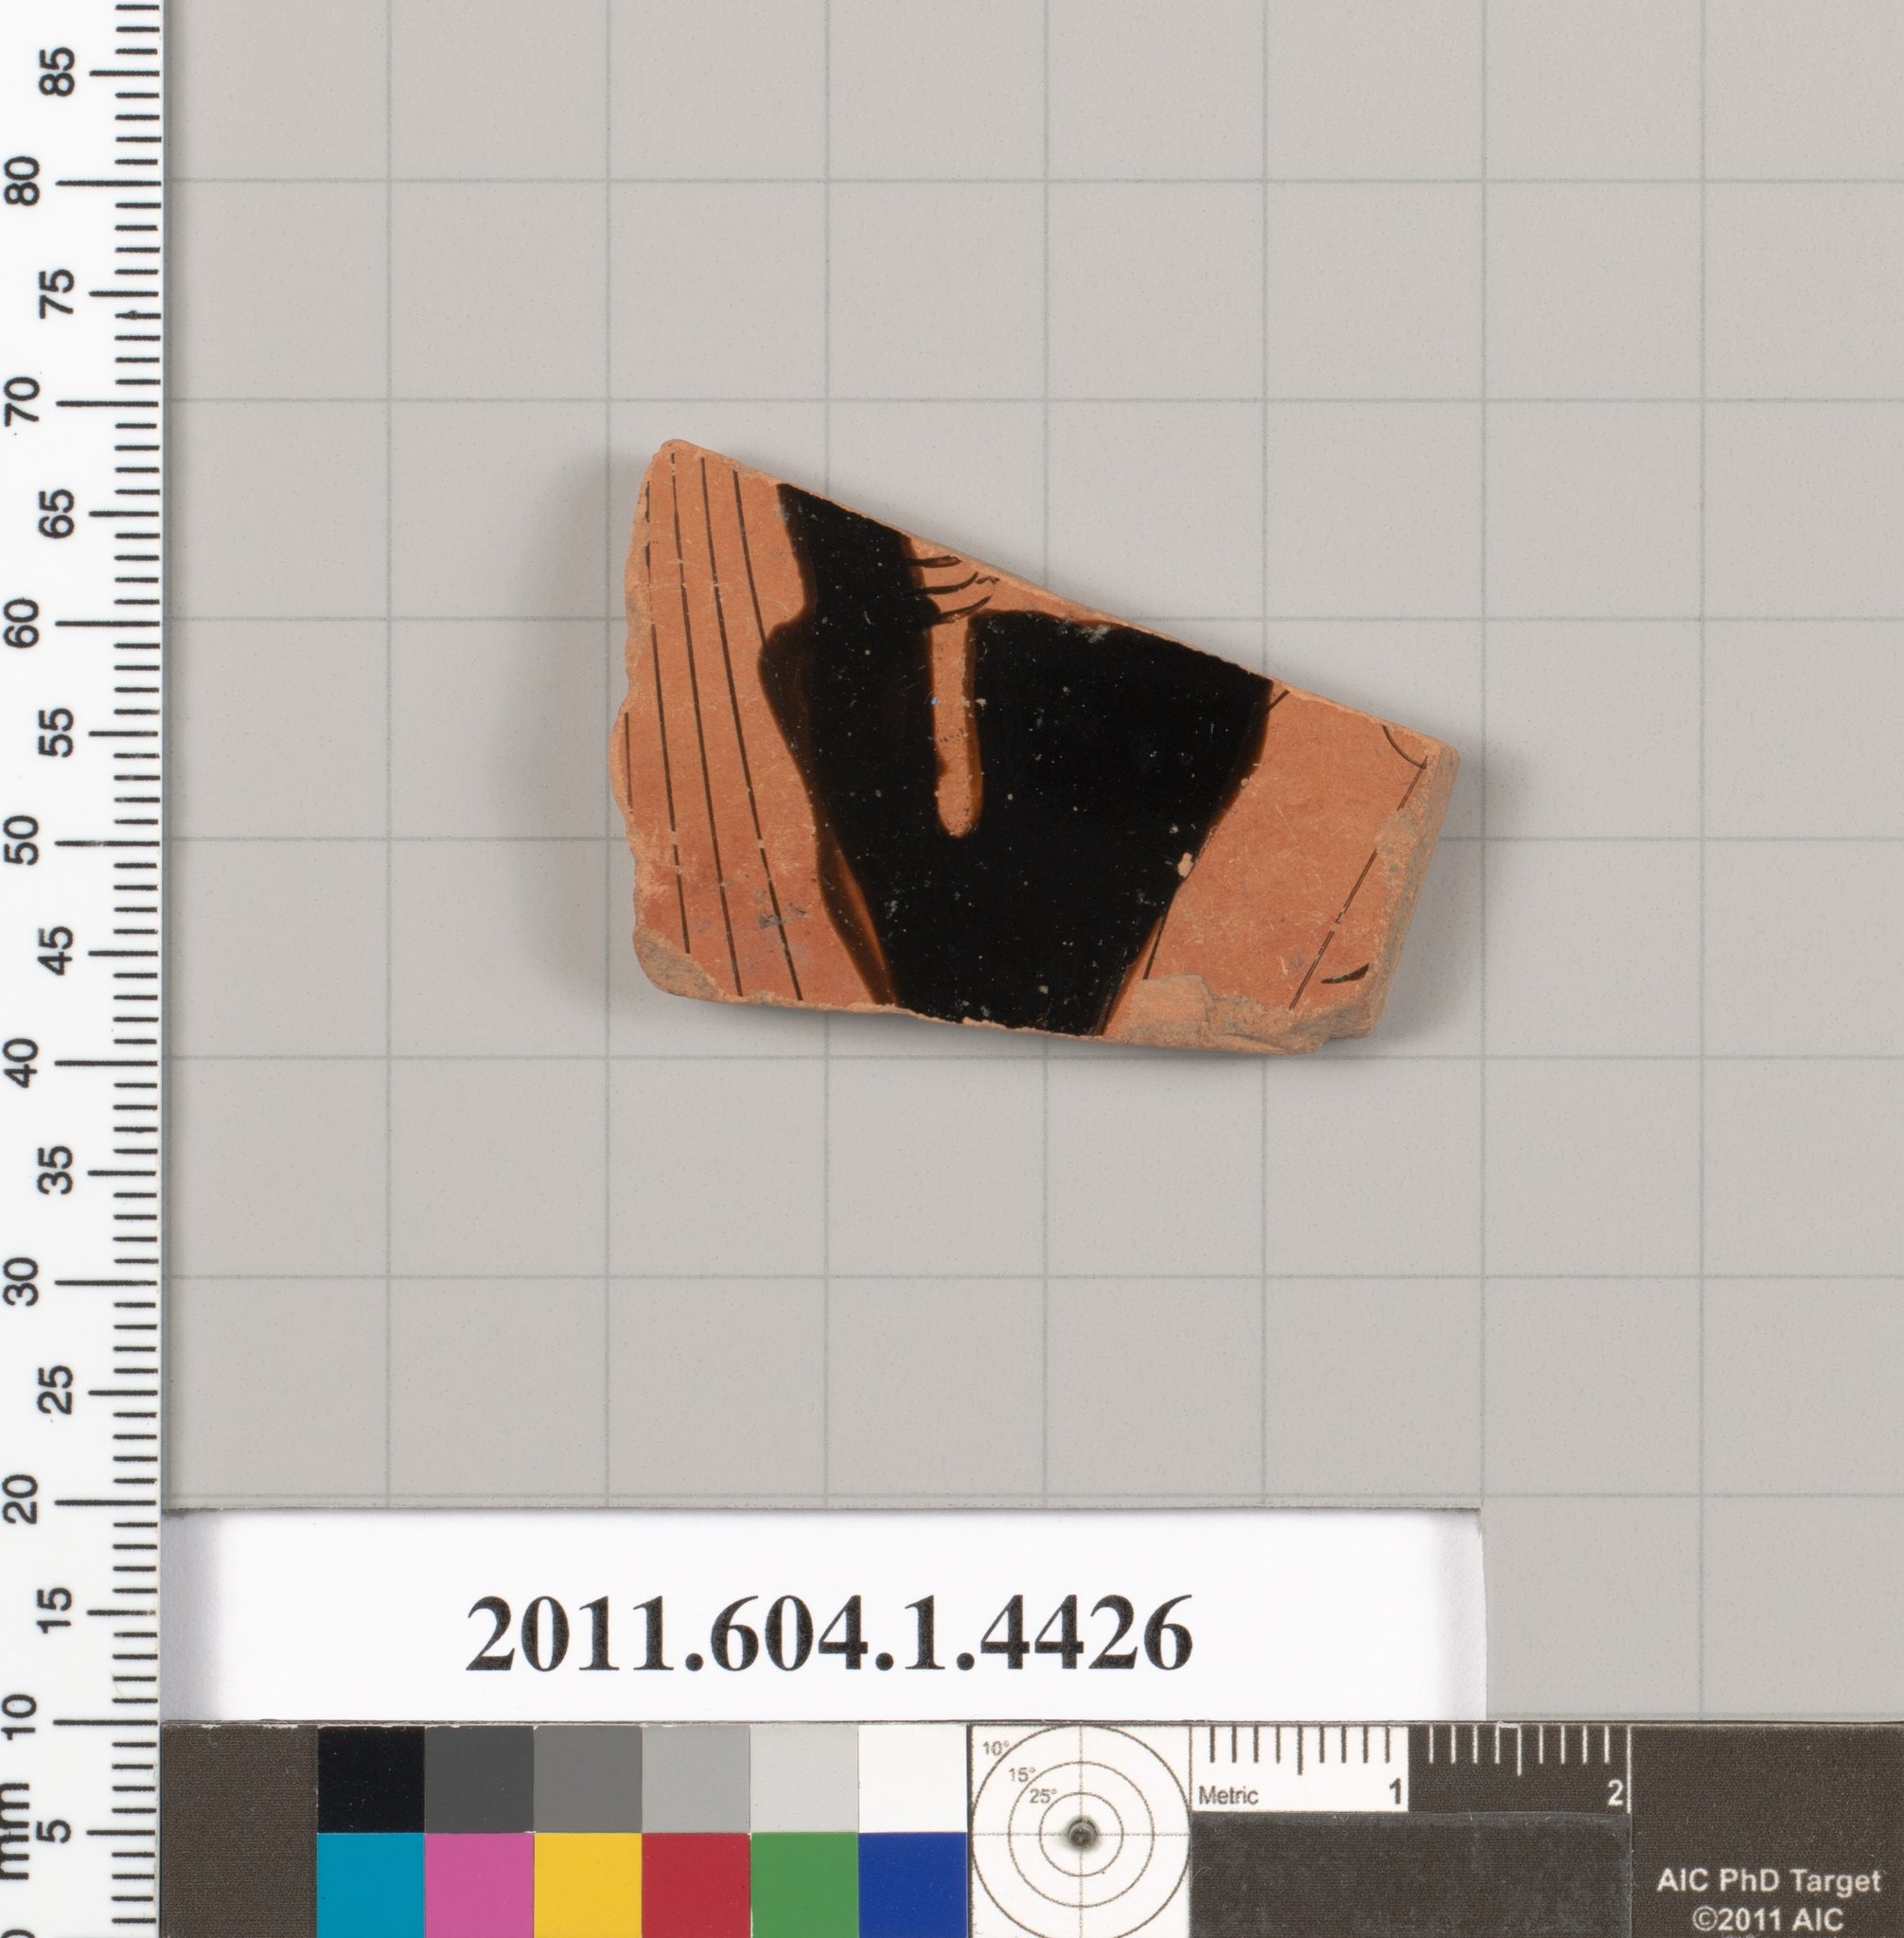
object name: kylix fragment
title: Terracotta fragment of a kylix (drinking cup)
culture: greek, attic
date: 475-451 BCE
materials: terracotta